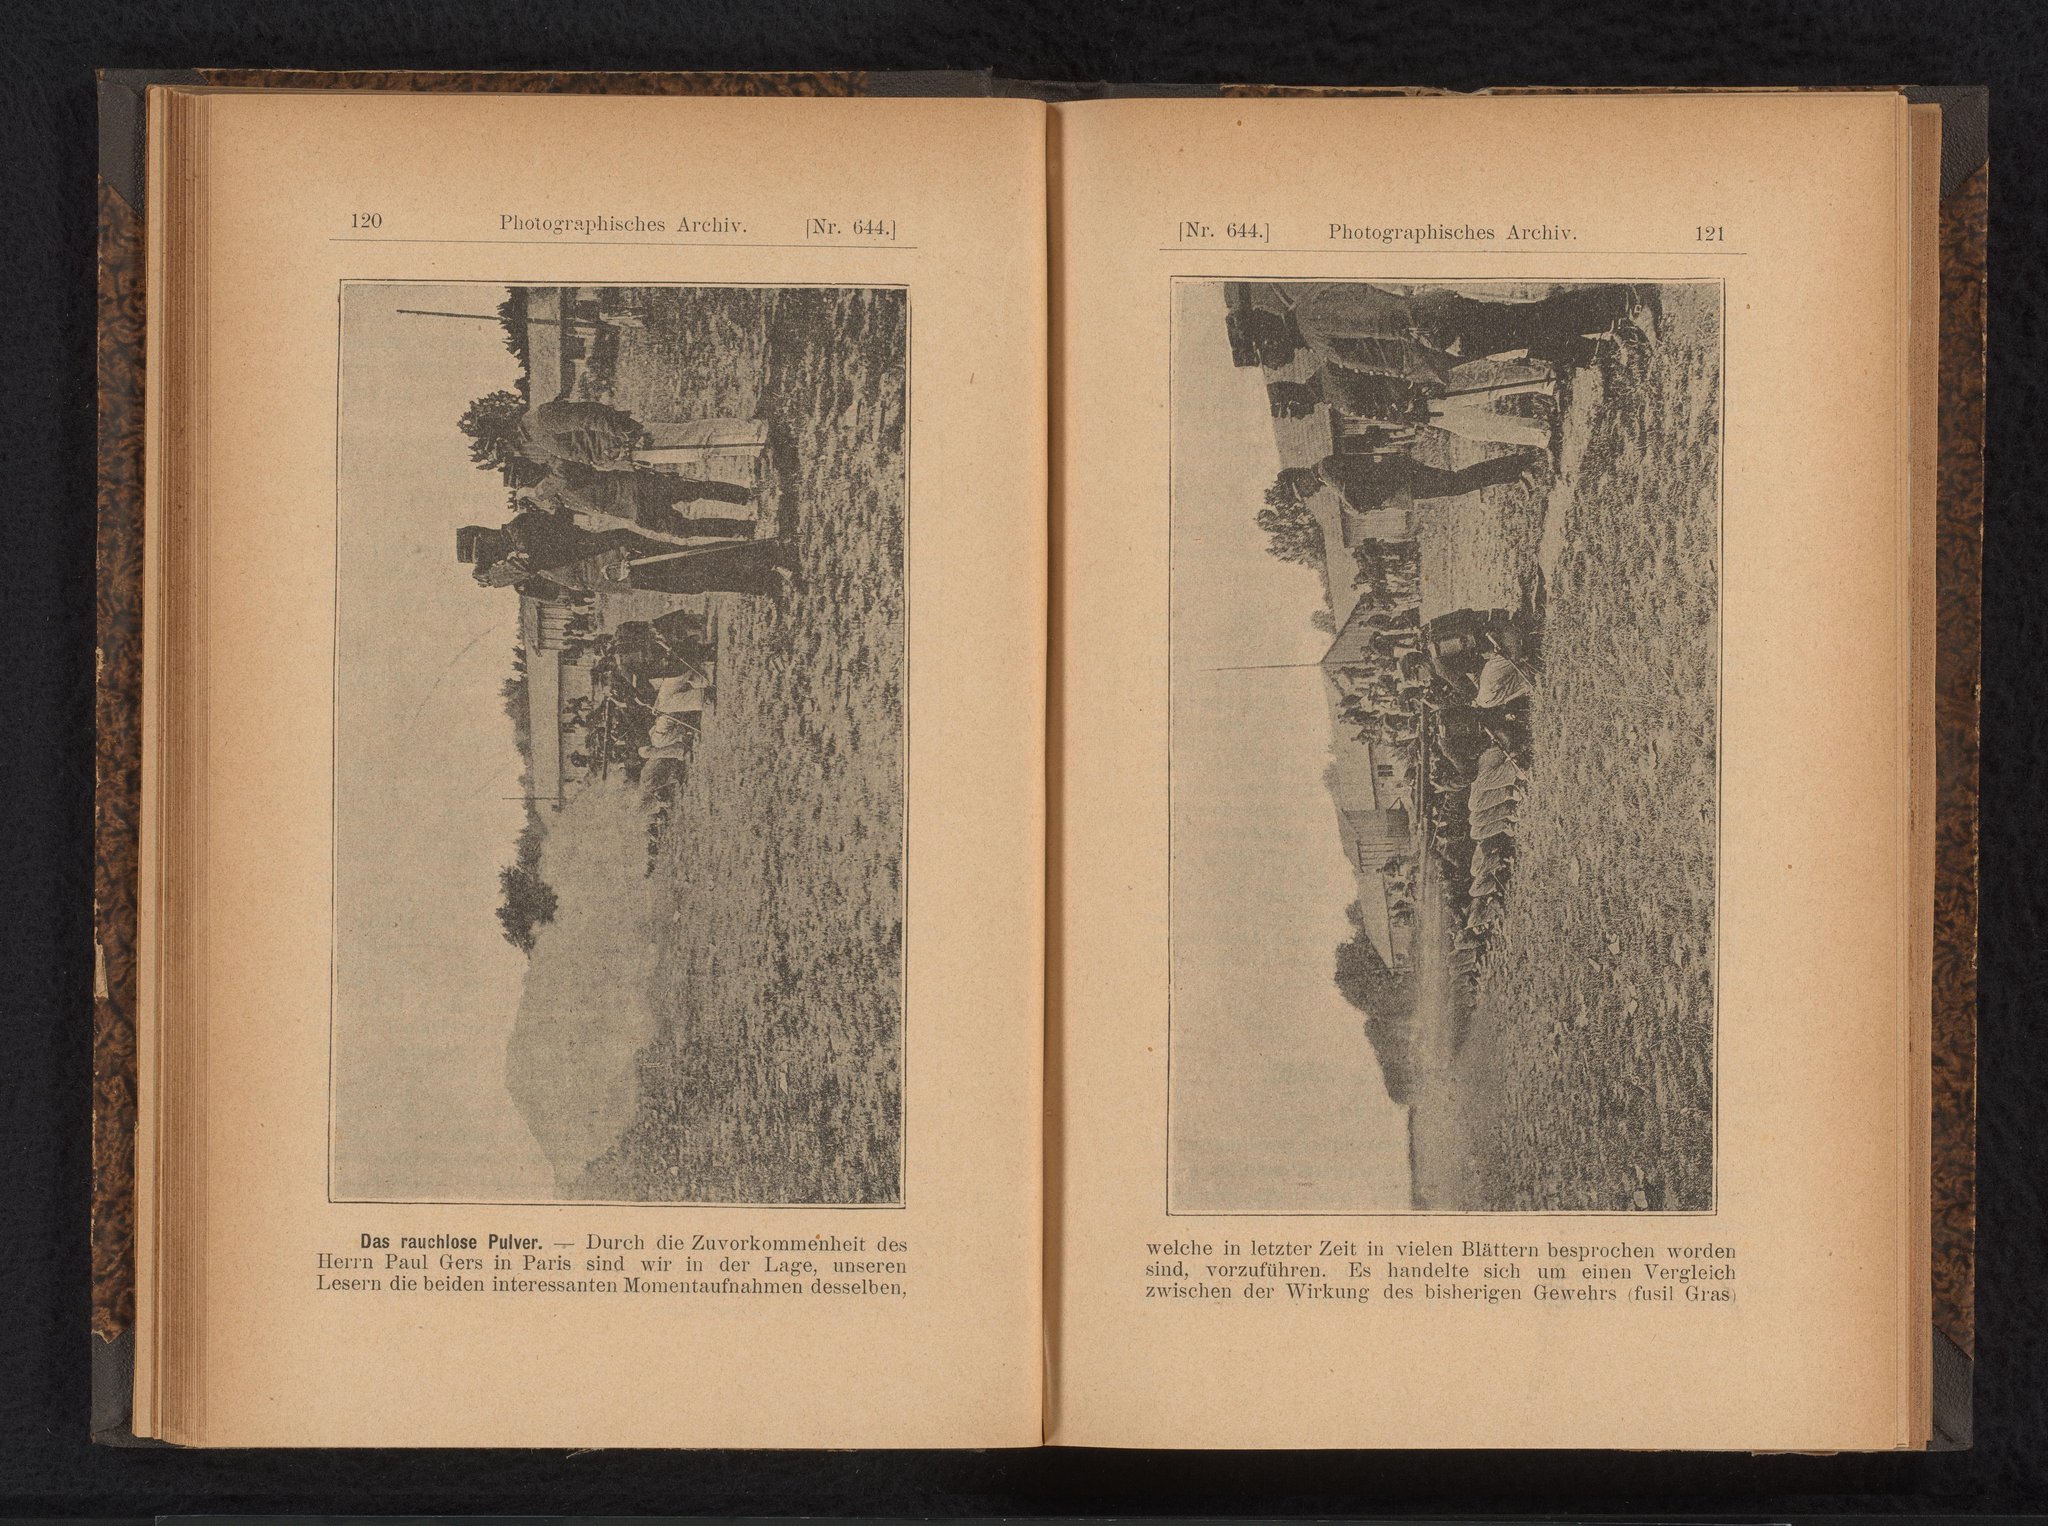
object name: page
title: Militairen schieten met oude geweren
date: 1805-1889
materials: paper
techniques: autotype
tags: artillery range, firing range, shooting range ~ military training, firearms: rifle